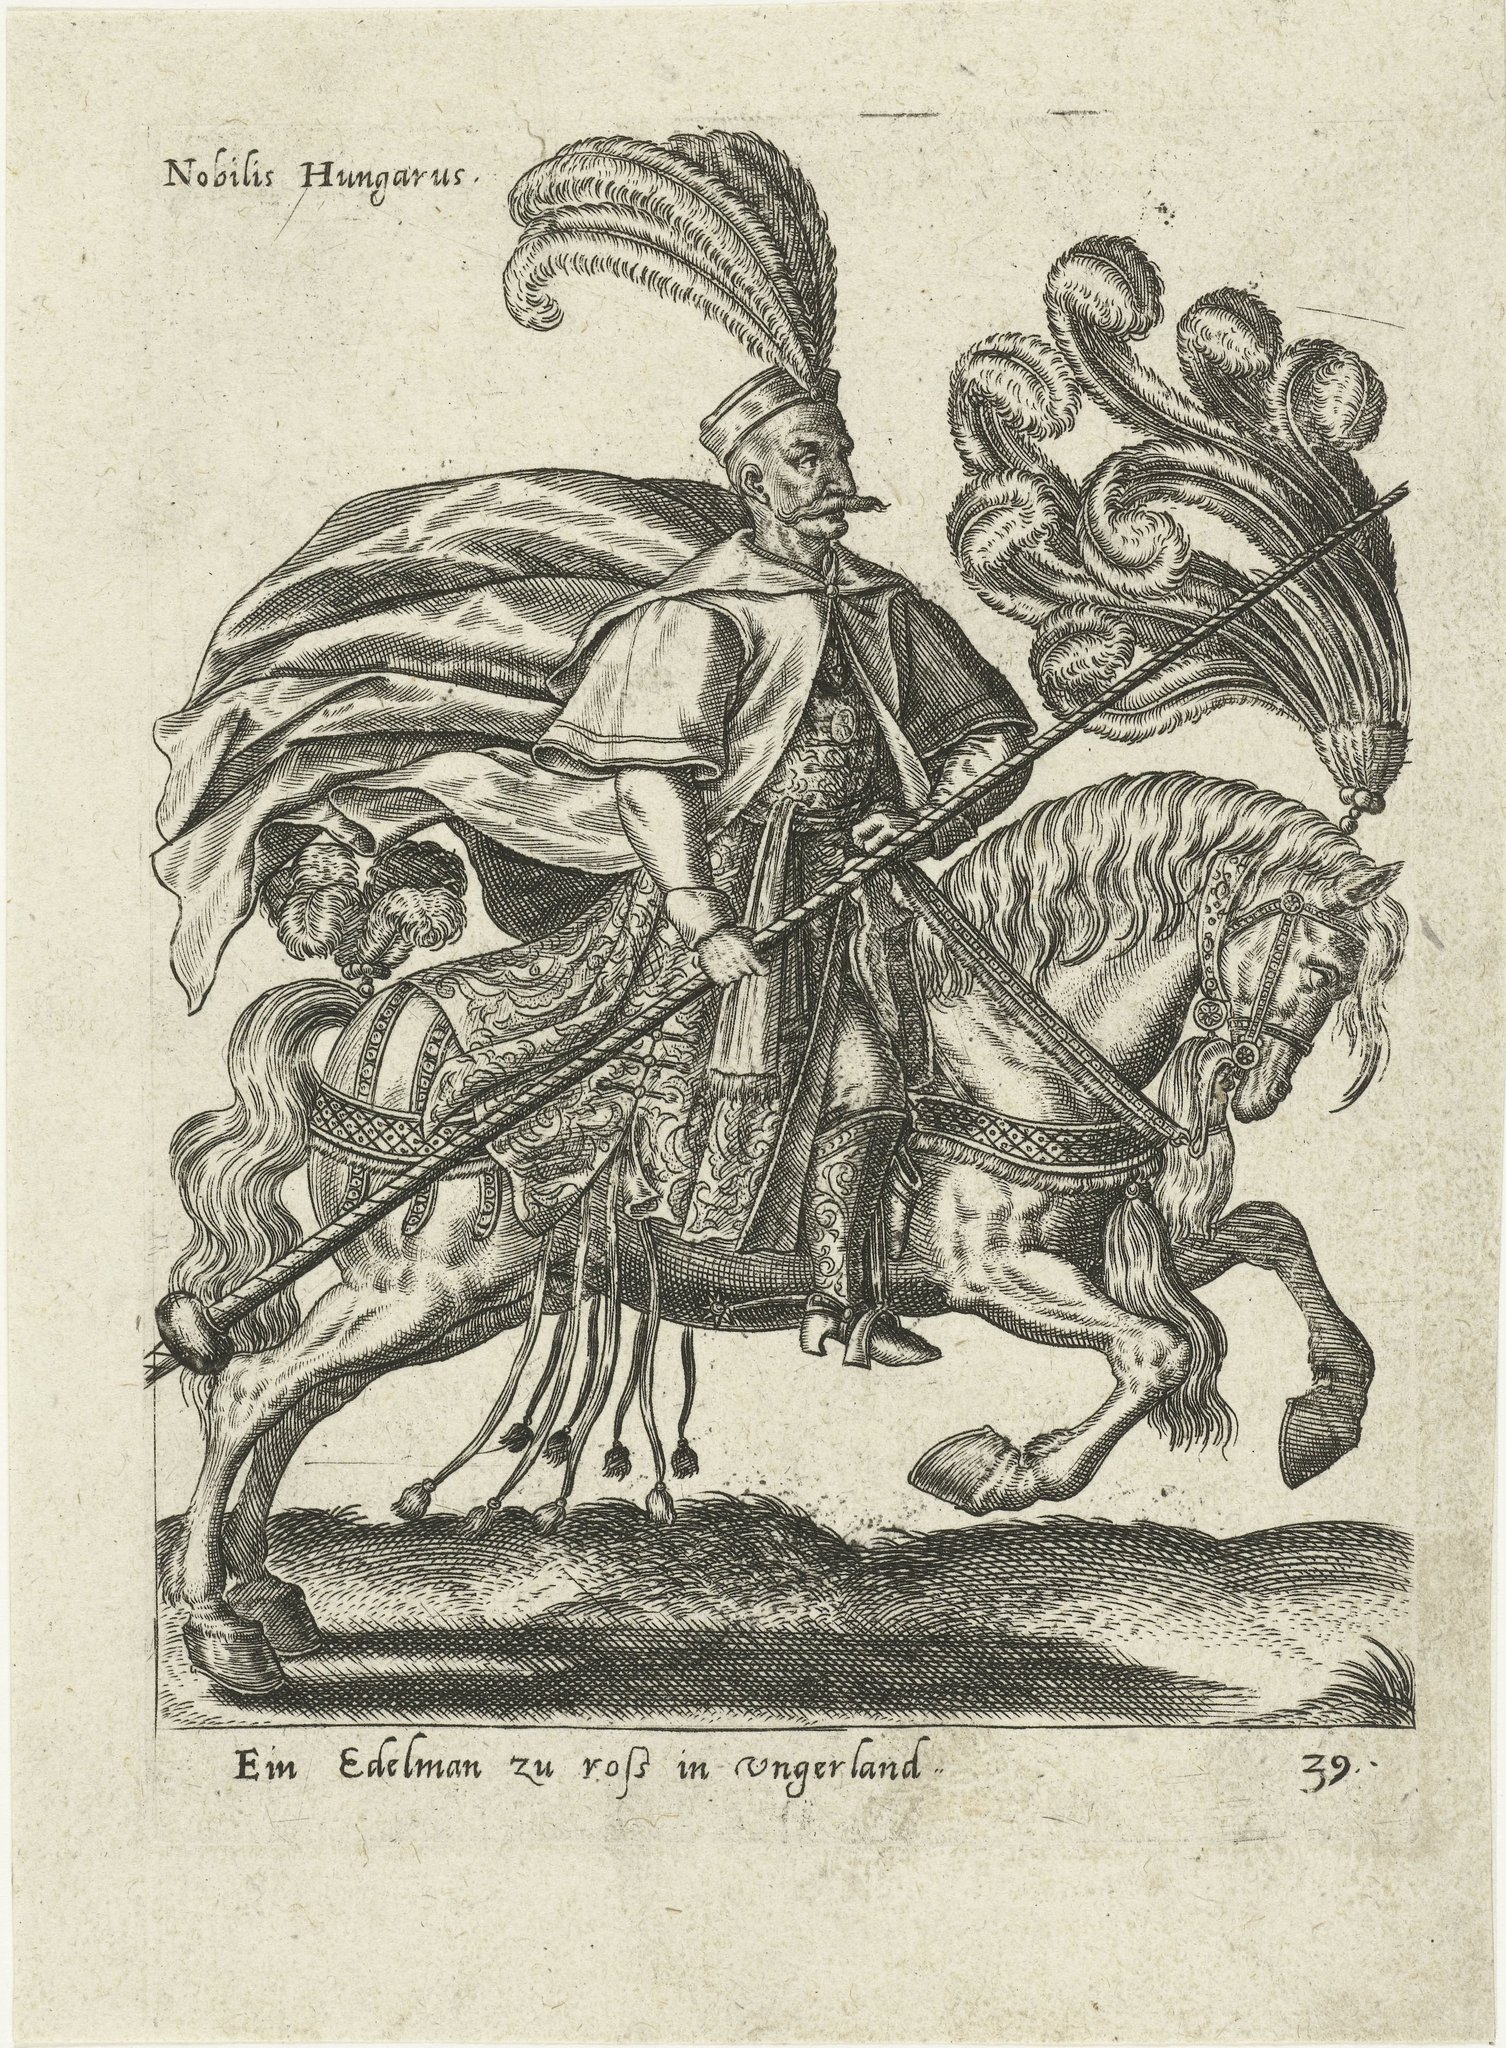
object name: costume print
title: Hongaarse edelman te paard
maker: abraham de bruyn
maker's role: print maker, publisher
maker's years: 1540-1587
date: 1577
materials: paper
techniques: engraving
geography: cologne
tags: europeans (with name), warfare; military affairs (+ cavalry, horsemen), folk costume, regional costume, nobility and patriciate; chivalry, knighthood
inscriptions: collector's mark: Lugt 2228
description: Paard en ruiter naar rechts. Het paard is in galop. De edelman heeft Hongaarse kleding aan en heeft een lans in zijn hand. De prent heeft een Duits onderschrift en een Latijns opschrift. Prent oorspronkelijk uit 'Equitum descripcio...', 1577.